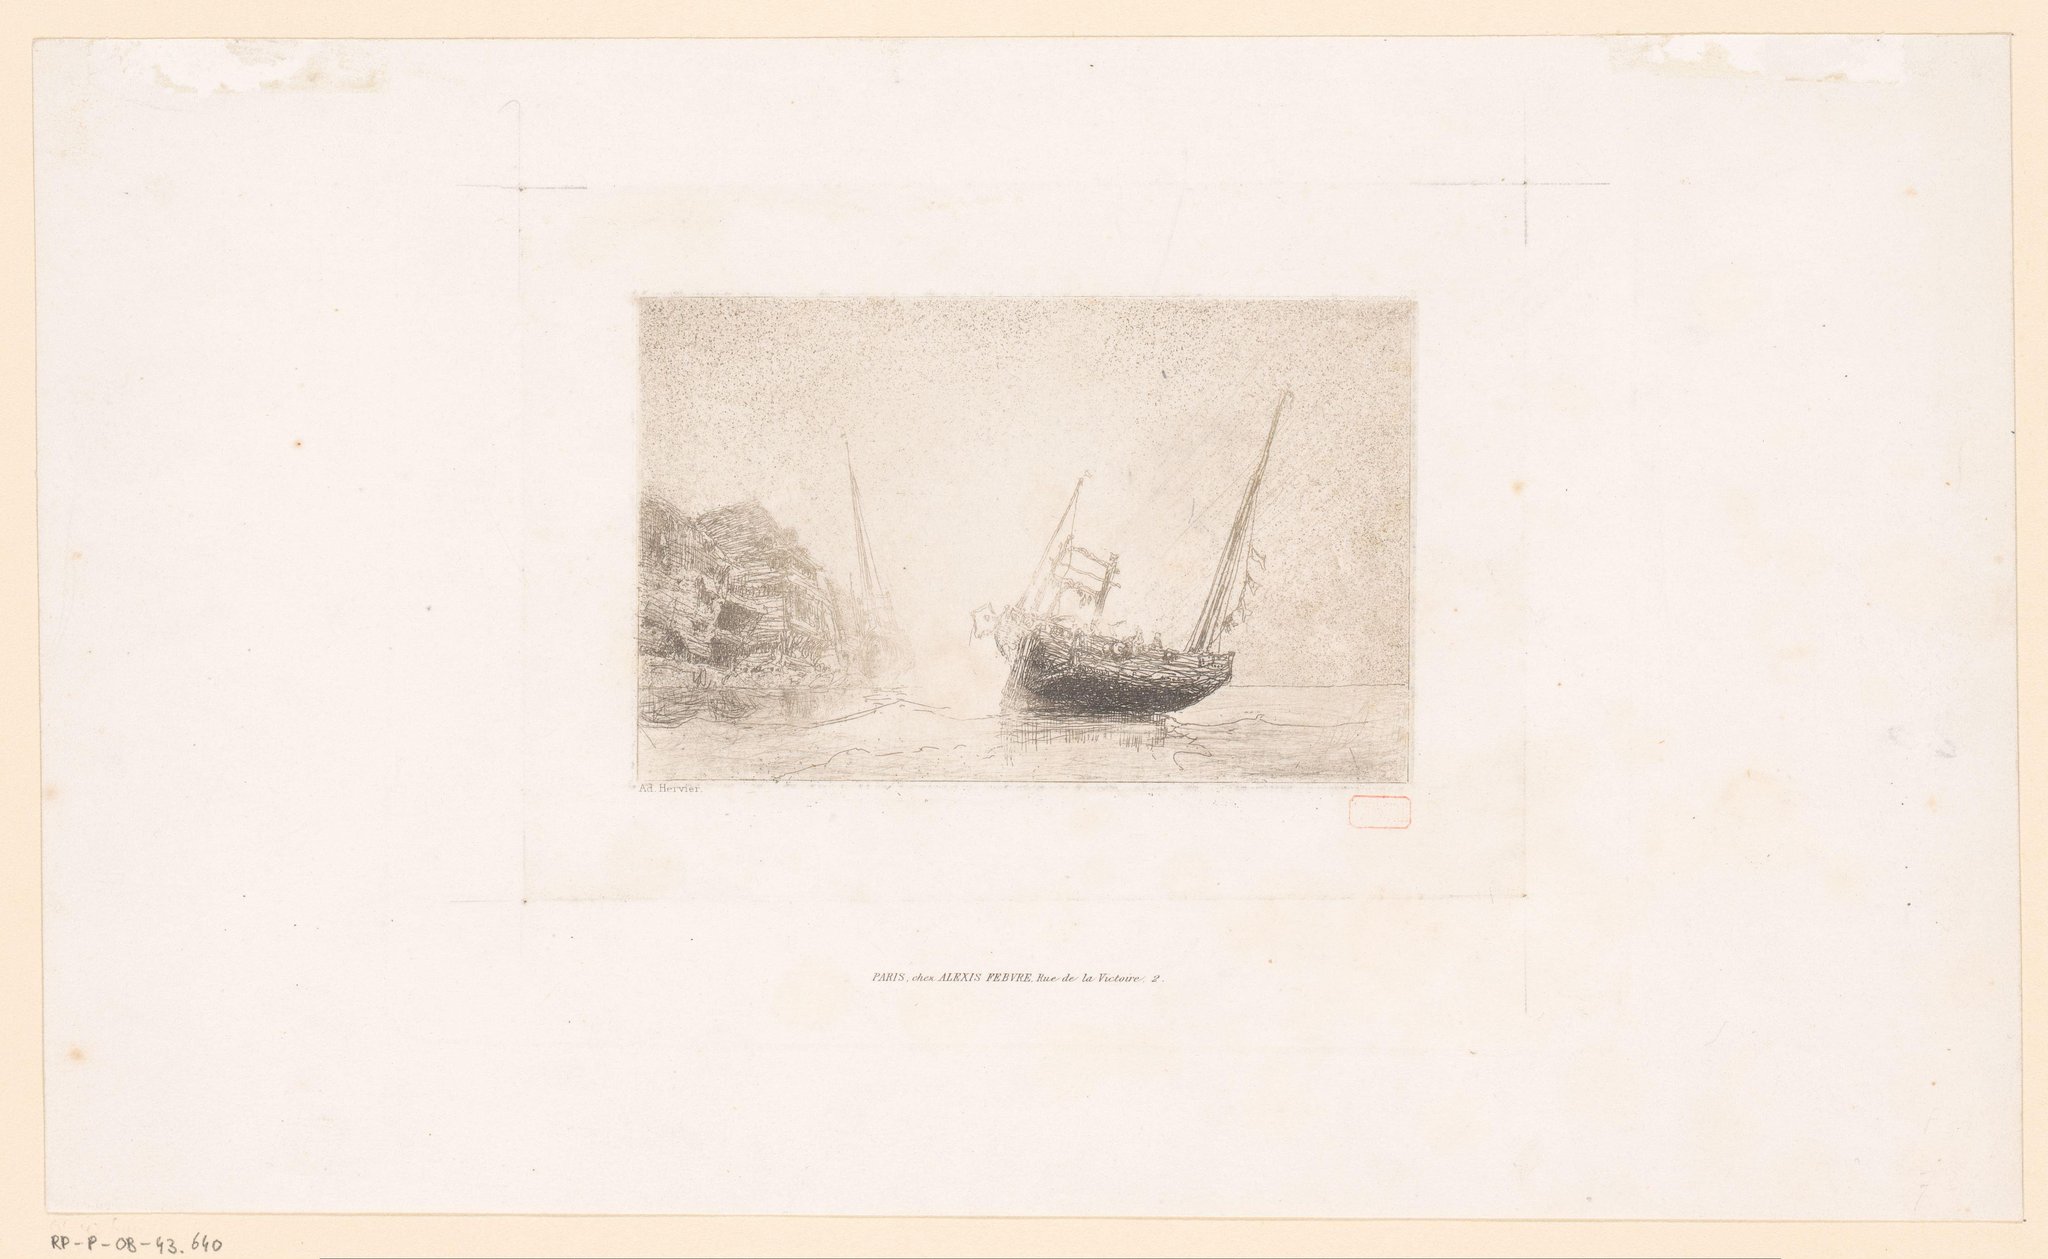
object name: print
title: Vastgelopen schip op het strand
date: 1828-1879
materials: paper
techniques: aquatint, etching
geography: paris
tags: sailing-ship, sailing-boat, beach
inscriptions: collector's mark: Lugt 2228, stamp: Lugt 922